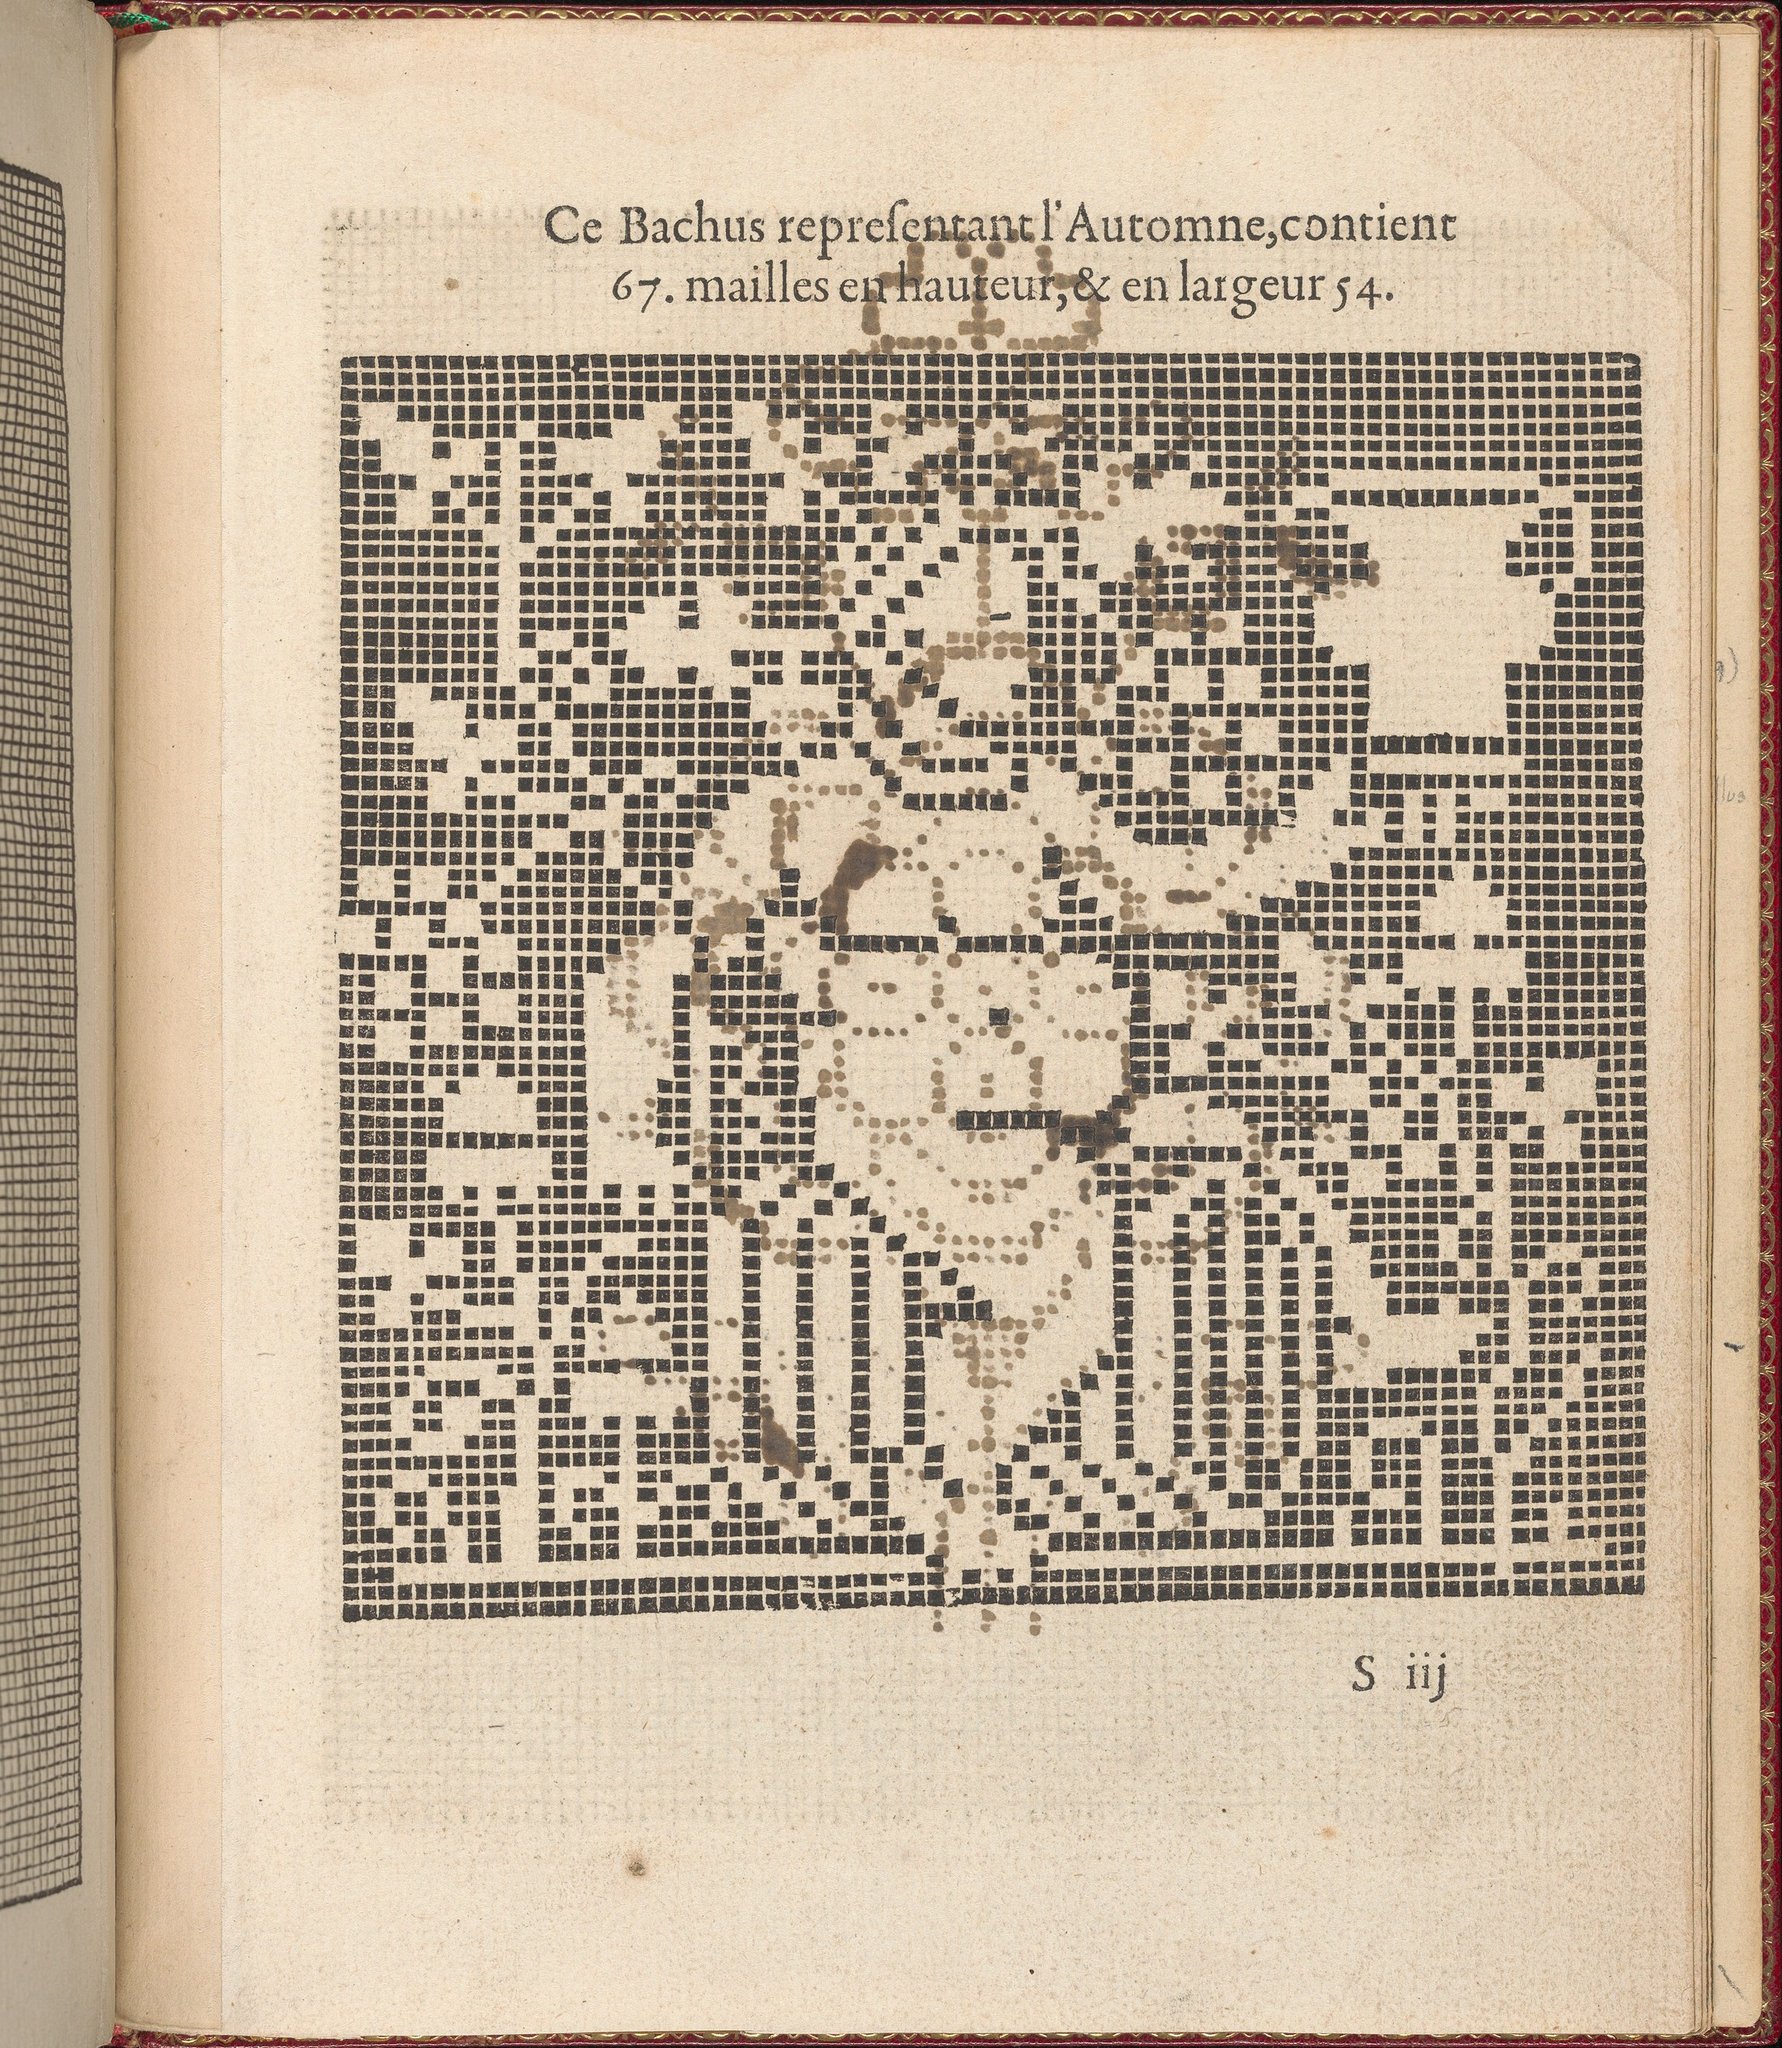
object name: book print ornament architecture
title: Les Singuliers et Nouveaux Portraicts... page 71 (recto)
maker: federico de vinciolo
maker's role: designer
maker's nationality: italian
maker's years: 1582-1599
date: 1588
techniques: woodcut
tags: ornament,bacchus